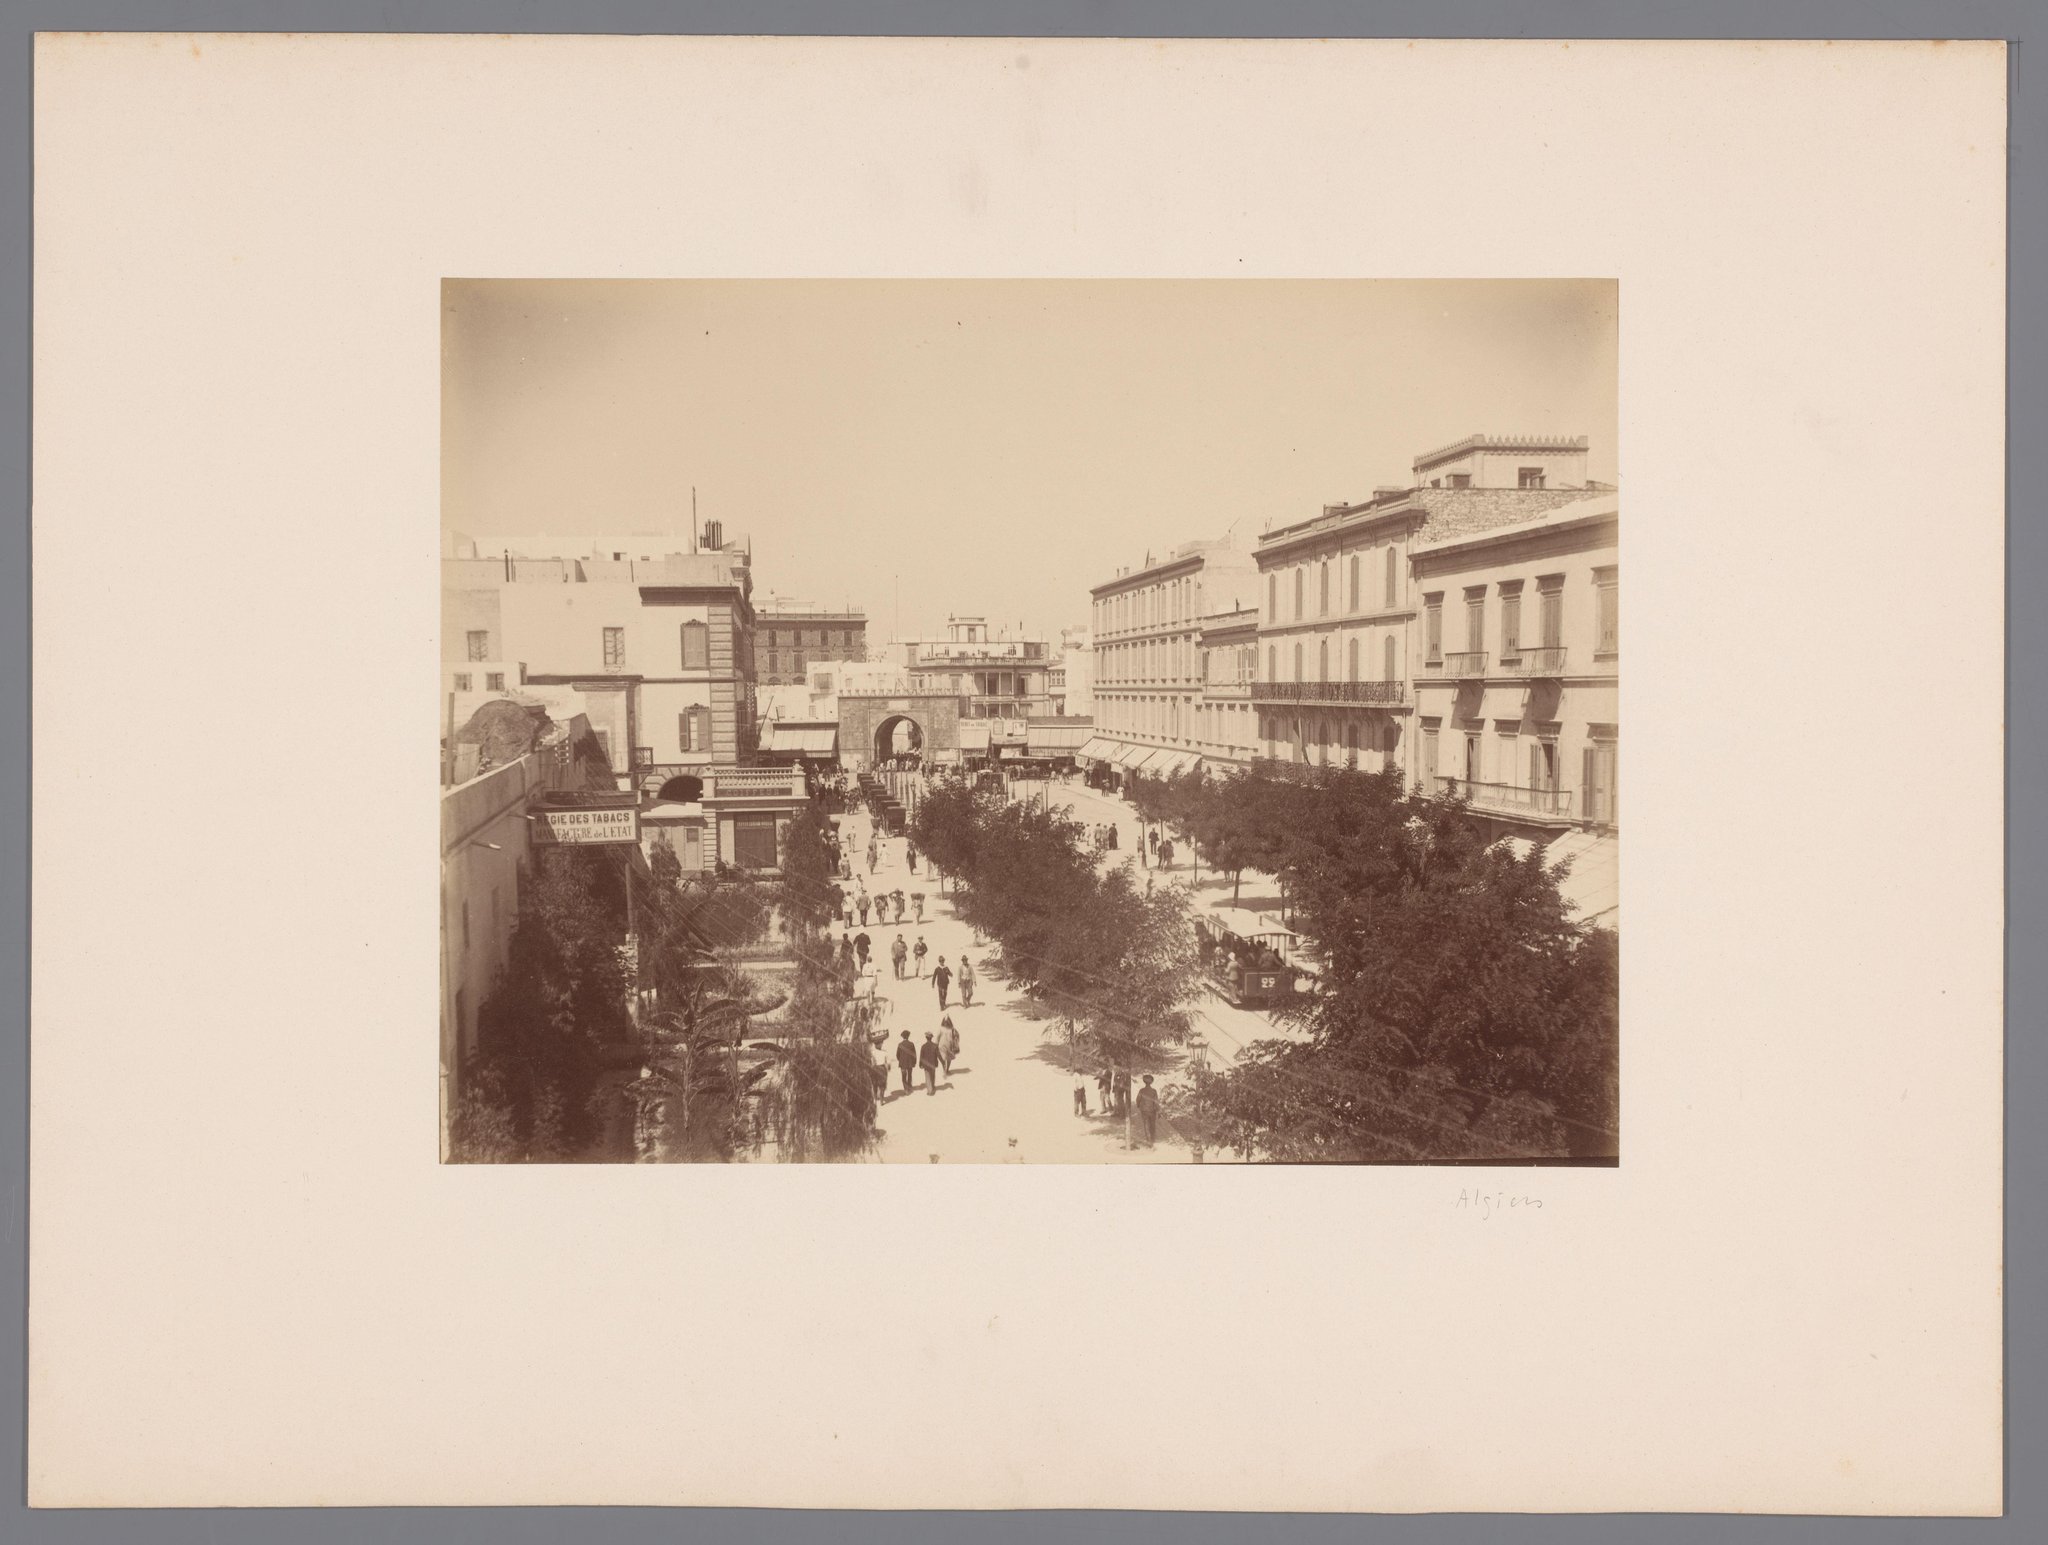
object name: photograph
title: Straatgezicht in Algiers [?], Algerije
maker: Anonymous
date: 1860-1890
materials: cardboard, photographic support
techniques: albumen print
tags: algiers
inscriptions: inscription: ‘Algiers’